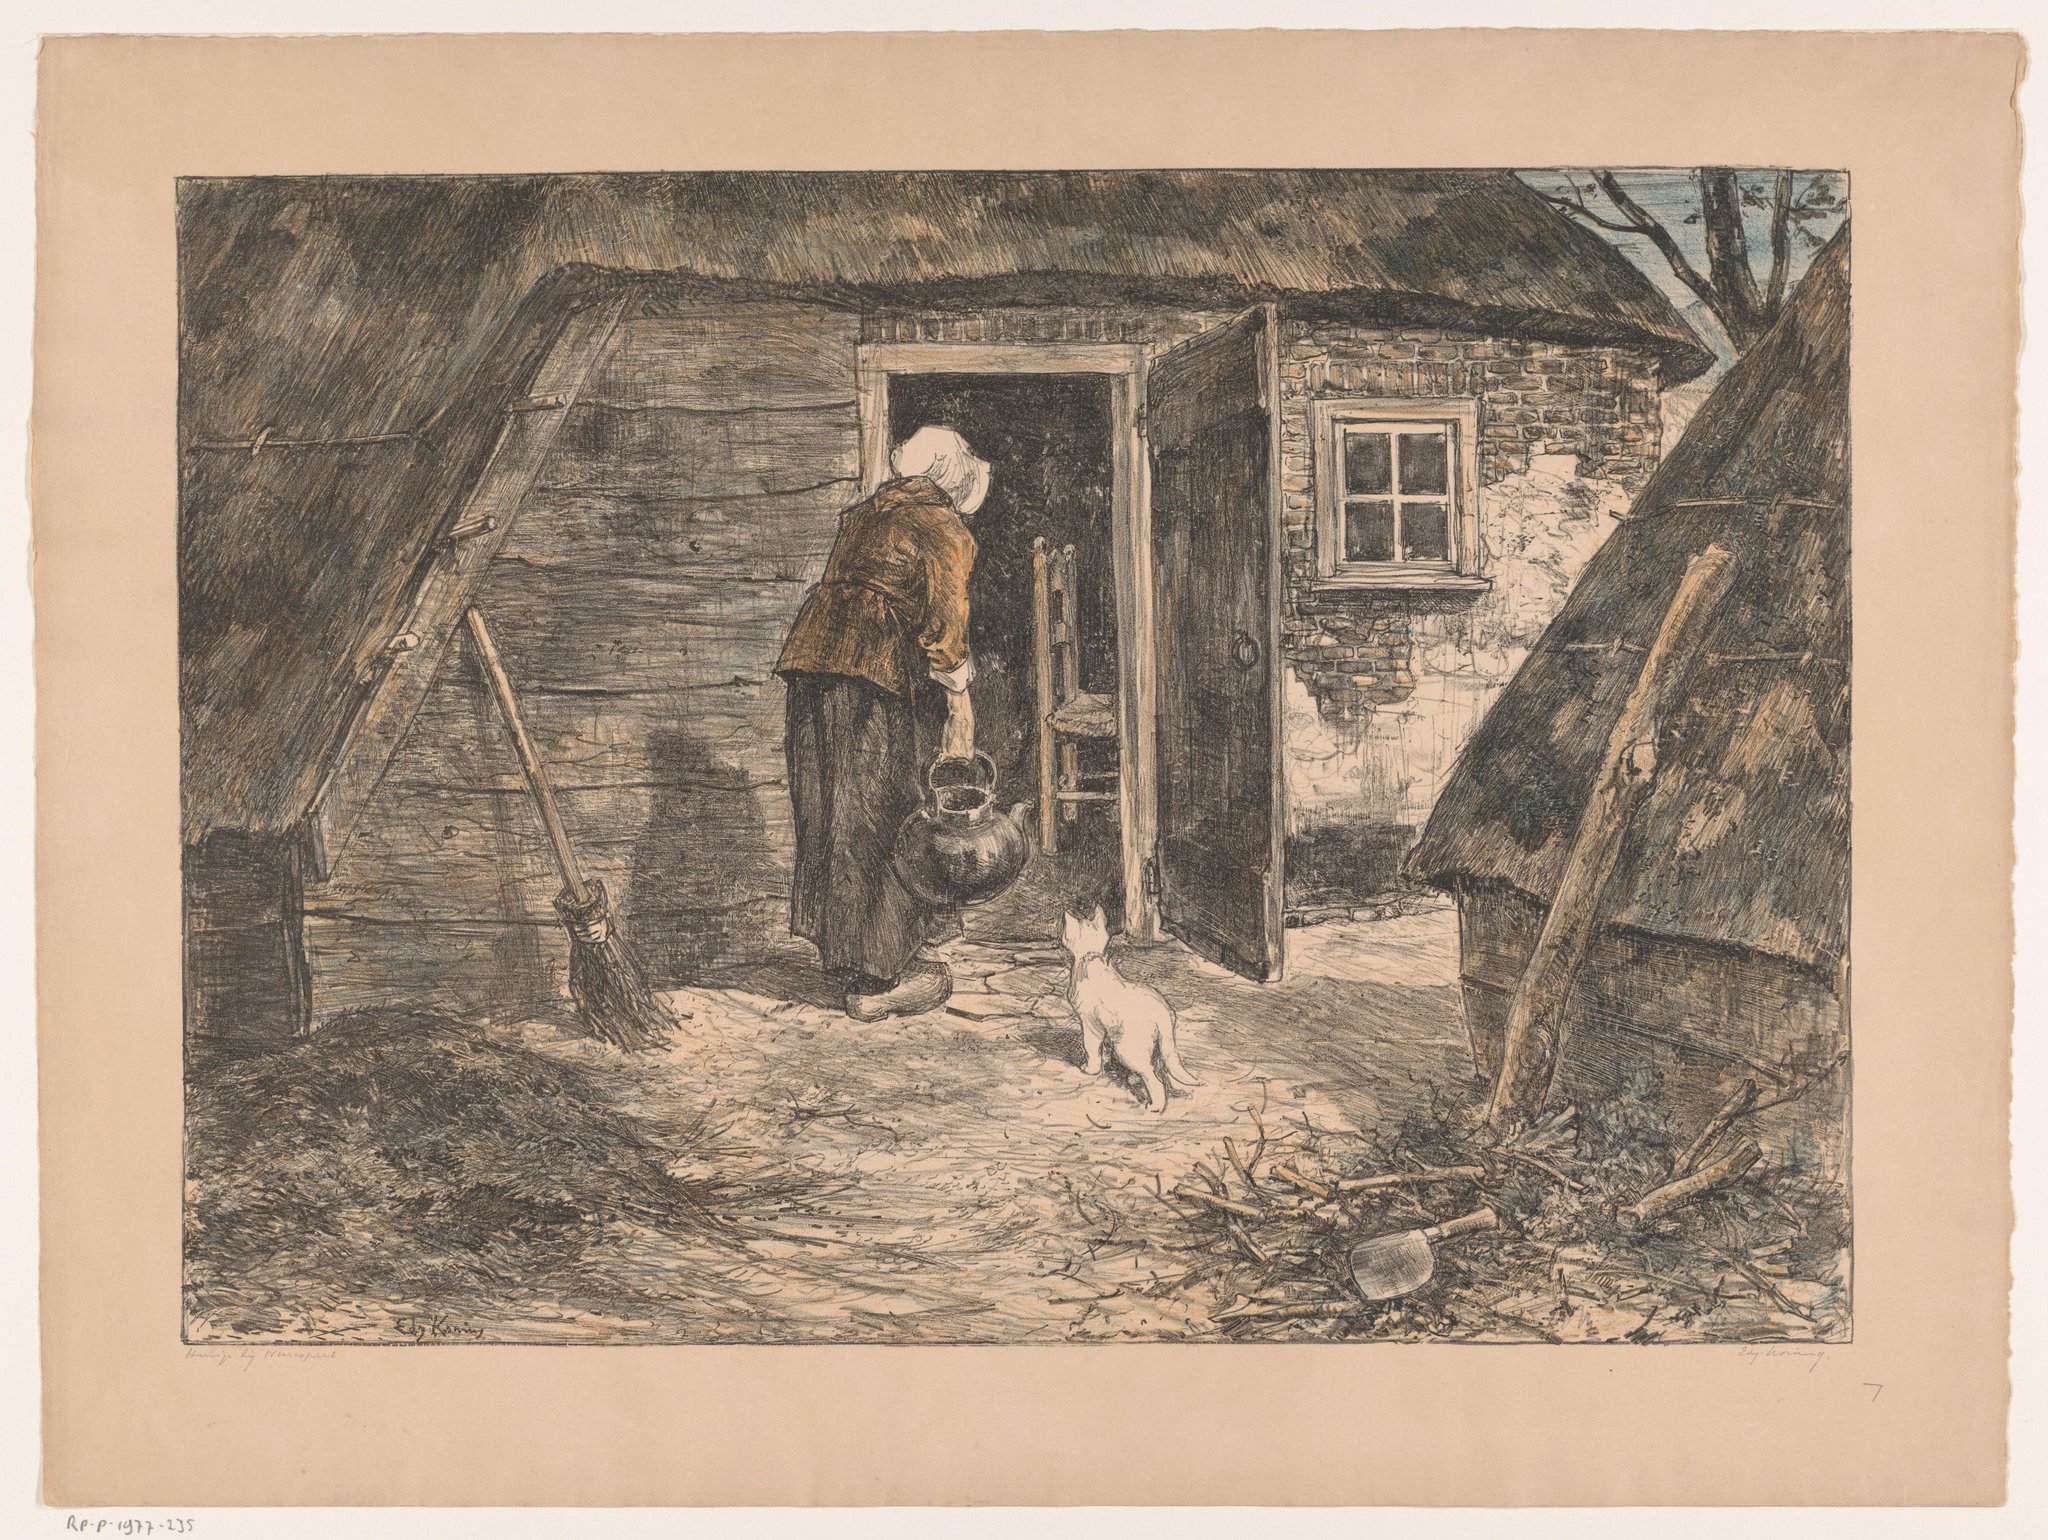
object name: print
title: Huisje bij Nunspeet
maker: edzard koning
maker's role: draughtsman, print maker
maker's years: 1869-1954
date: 1879-1954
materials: paper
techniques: lithograph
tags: cat, old woman, farm or solitary house in landscape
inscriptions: collector's mark: Lugt 2760, collector's mark: Lugt 2228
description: Boerenvrouw en poes bij de deur van een boerderij.